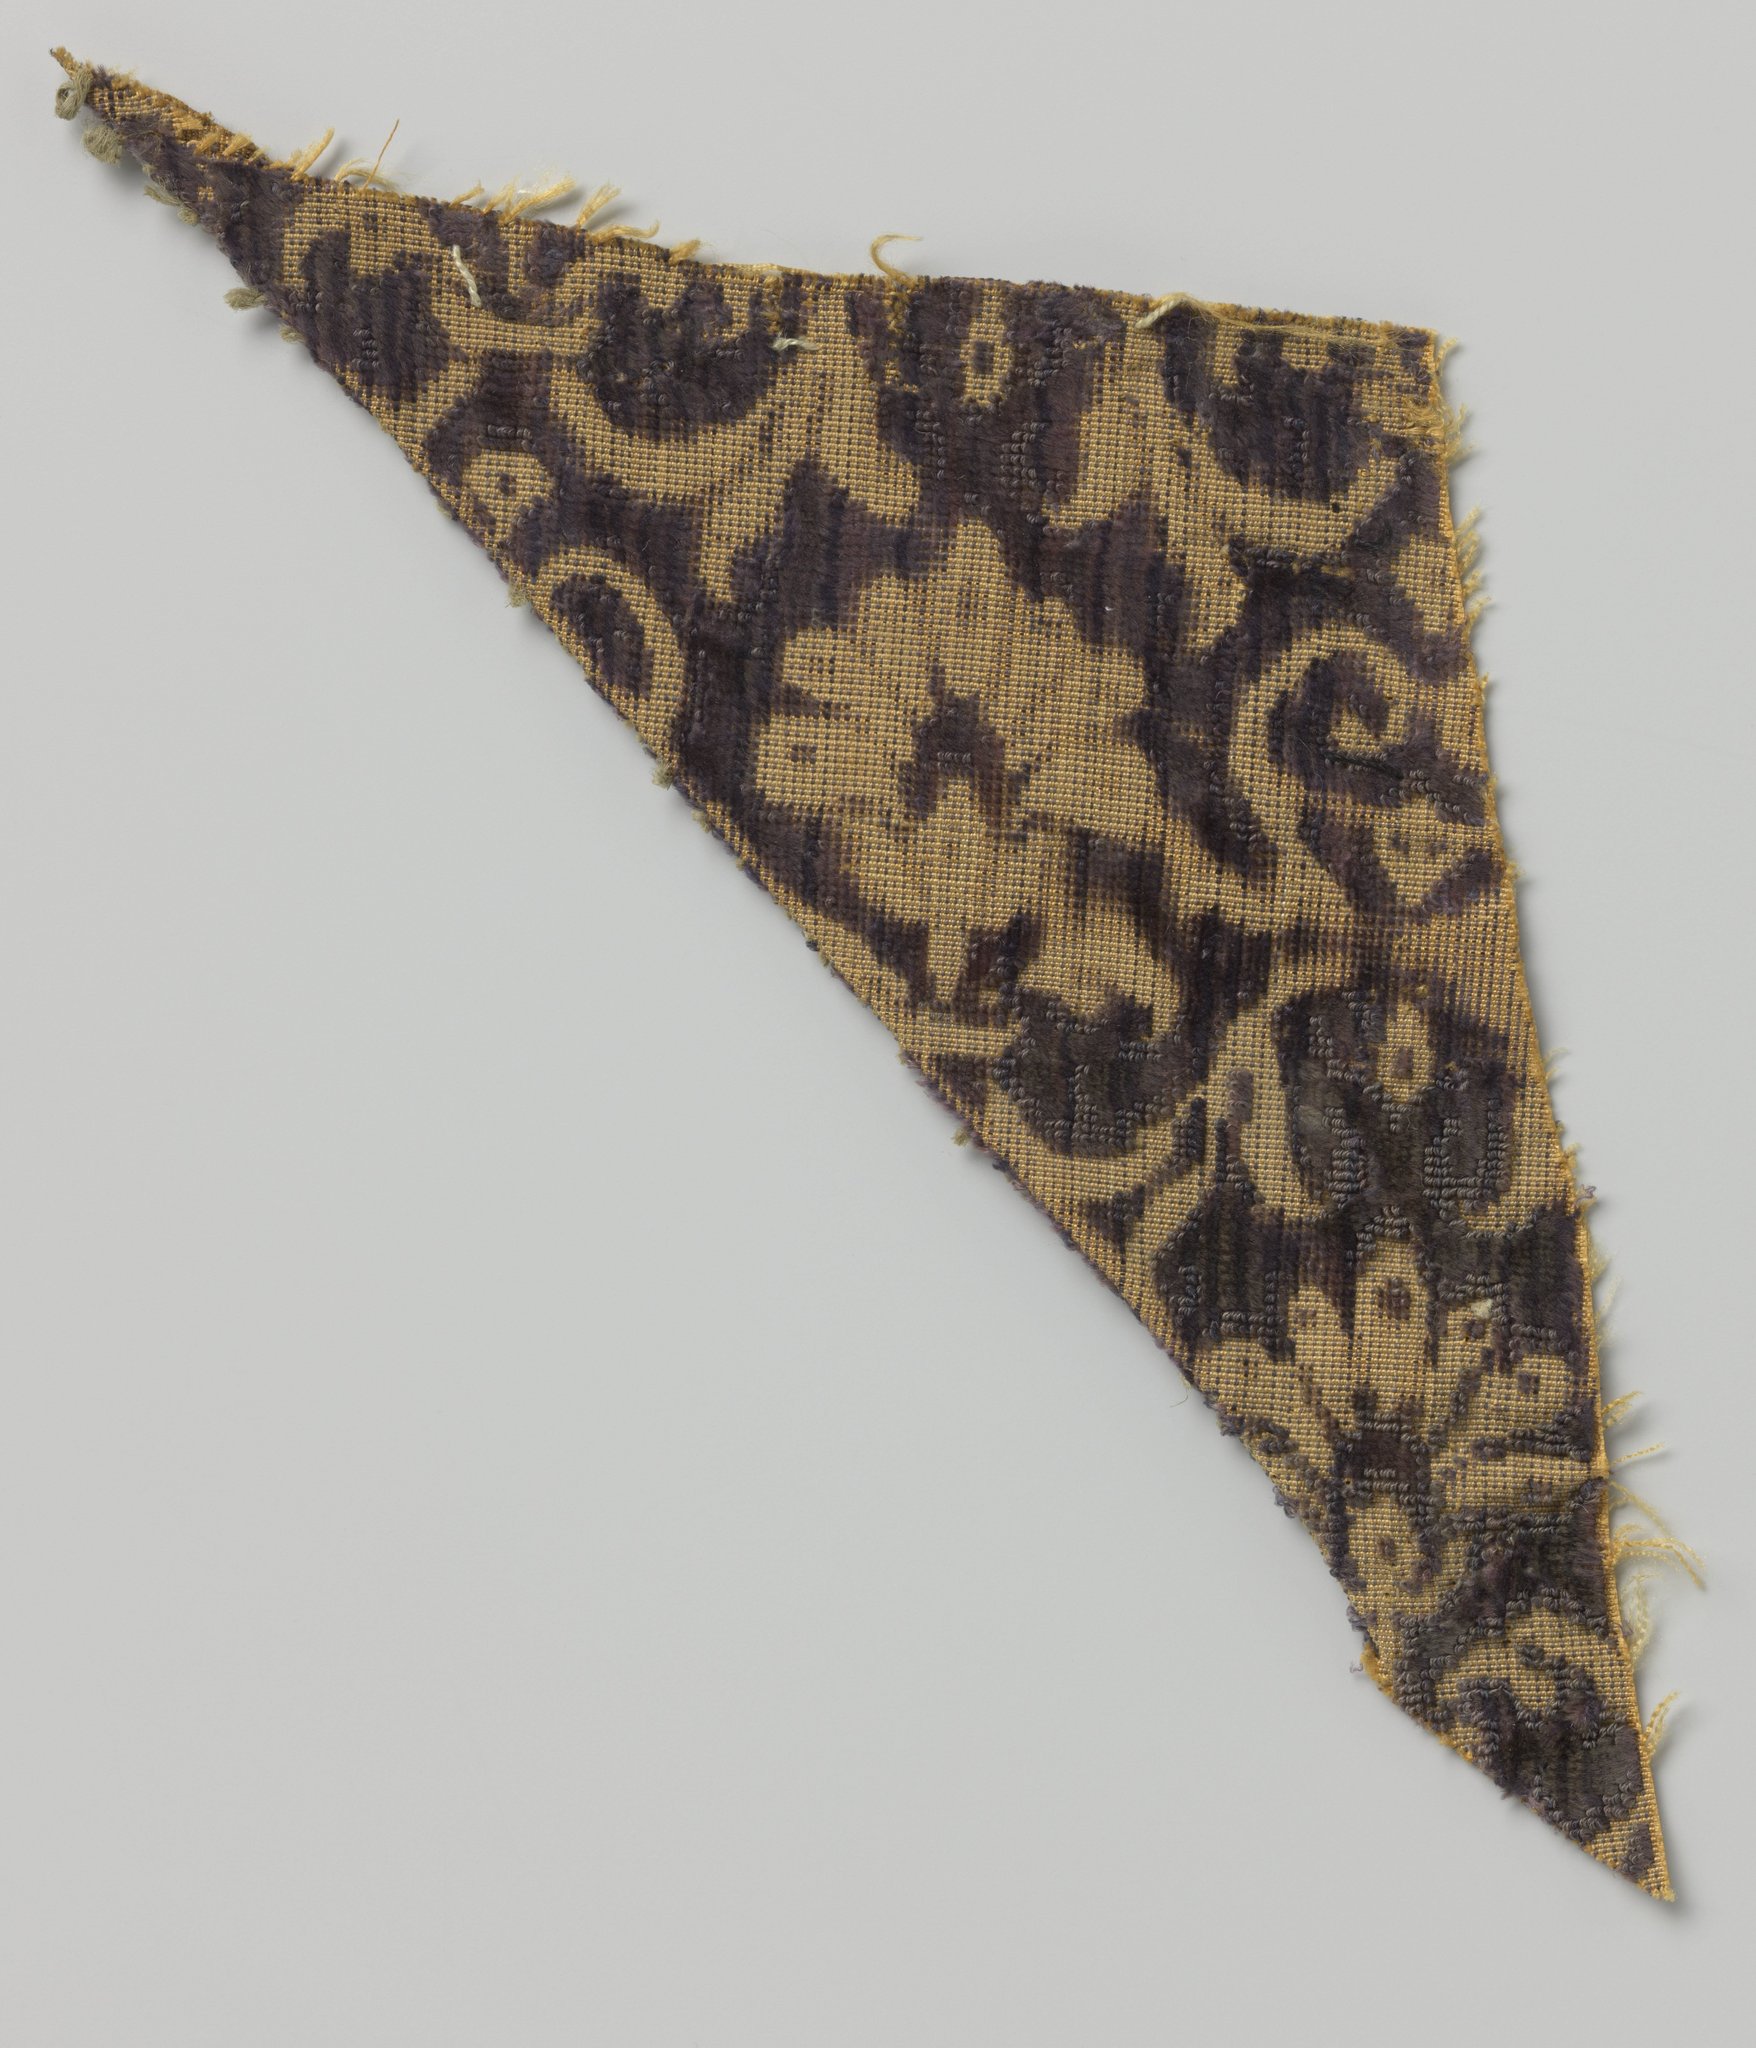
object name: fragment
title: Fragment zijden ciseléfluweel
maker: Anonymous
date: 1550-1650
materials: ciselé velvet, silk, velvet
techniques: weave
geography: italy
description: Driehoekig fragment paars zijden ciseléfluweelmet motief van palmetten en ranken in geel.